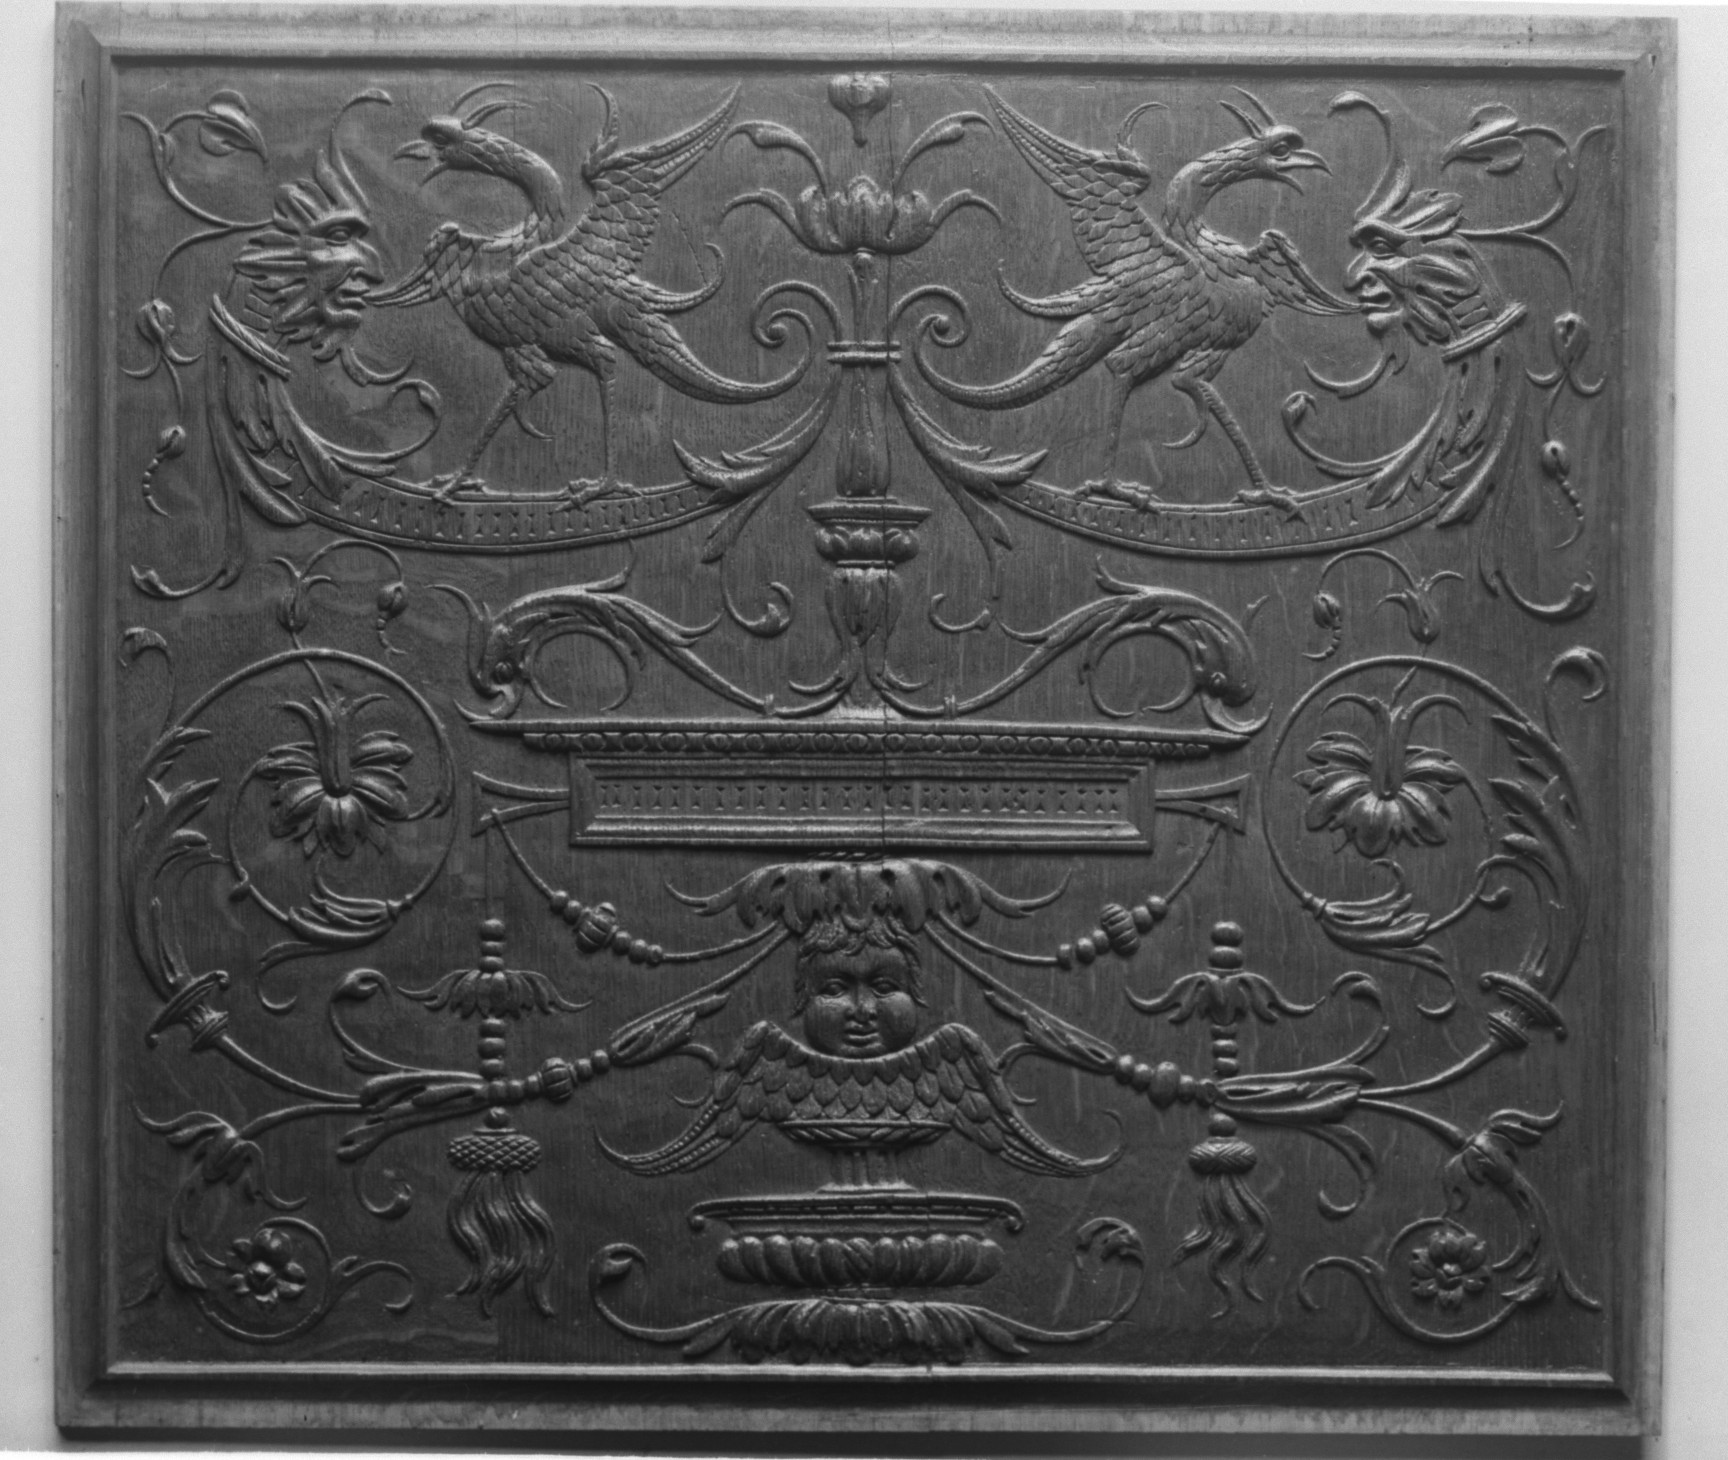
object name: panel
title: Panel (part of a set)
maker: nicolas castille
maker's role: maker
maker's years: 1503-1521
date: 1510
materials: wood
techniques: carving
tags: birds,faces,flowers